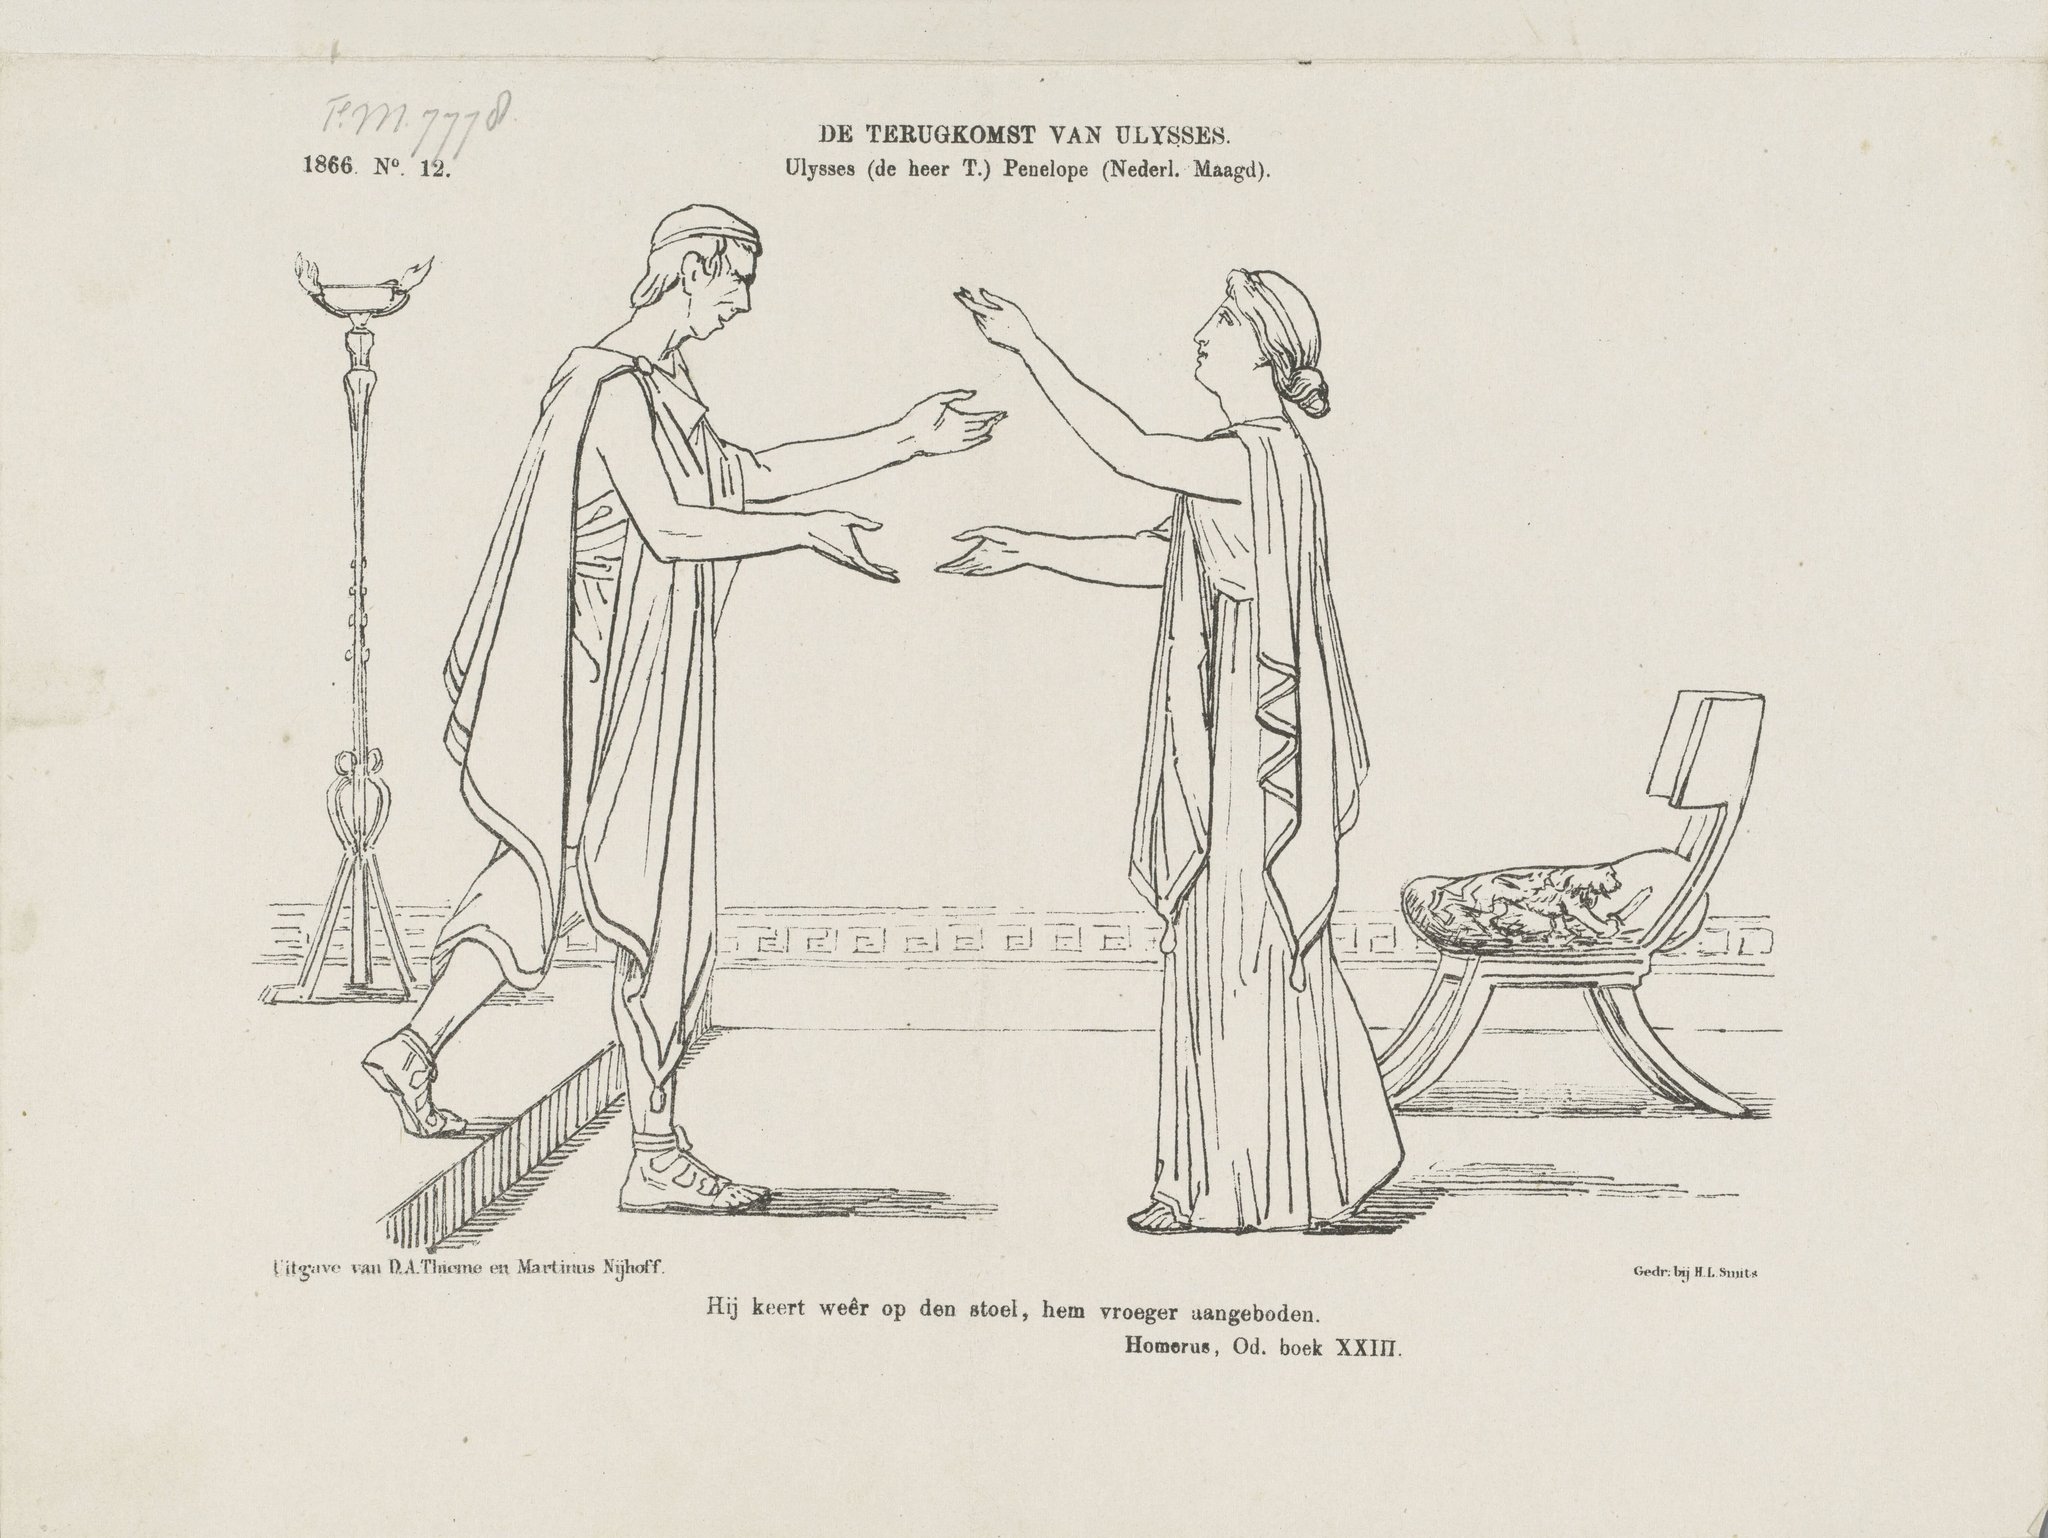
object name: print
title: Spotprent op de terugkeer van Thorbecke in de Tweede Kamer, 1866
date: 1866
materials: paper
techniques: lithograph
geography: arnhem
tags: johan rudolf thorbecke, personifications of countries, nations, states, districts, etc., penelope and ulysses reunited (homer, odyssey xxiii)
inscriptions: collector's mark: Lugt 2228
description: Spotprent op de terugkeer van Thorbecke in de Tweede Kamer, 1866. Thorbecke keert als Odysseus terug bij Penelope, de Nederlandse Maagd. Plaat verschenen bij het weekblad De Nederlandsche Spectator, nr. 12, 24 maart 1866.